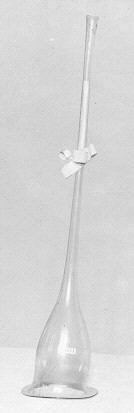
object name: trumpet in b flat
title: Trumpet in B-flat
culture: italian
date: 1801-1900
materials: glass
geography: italy